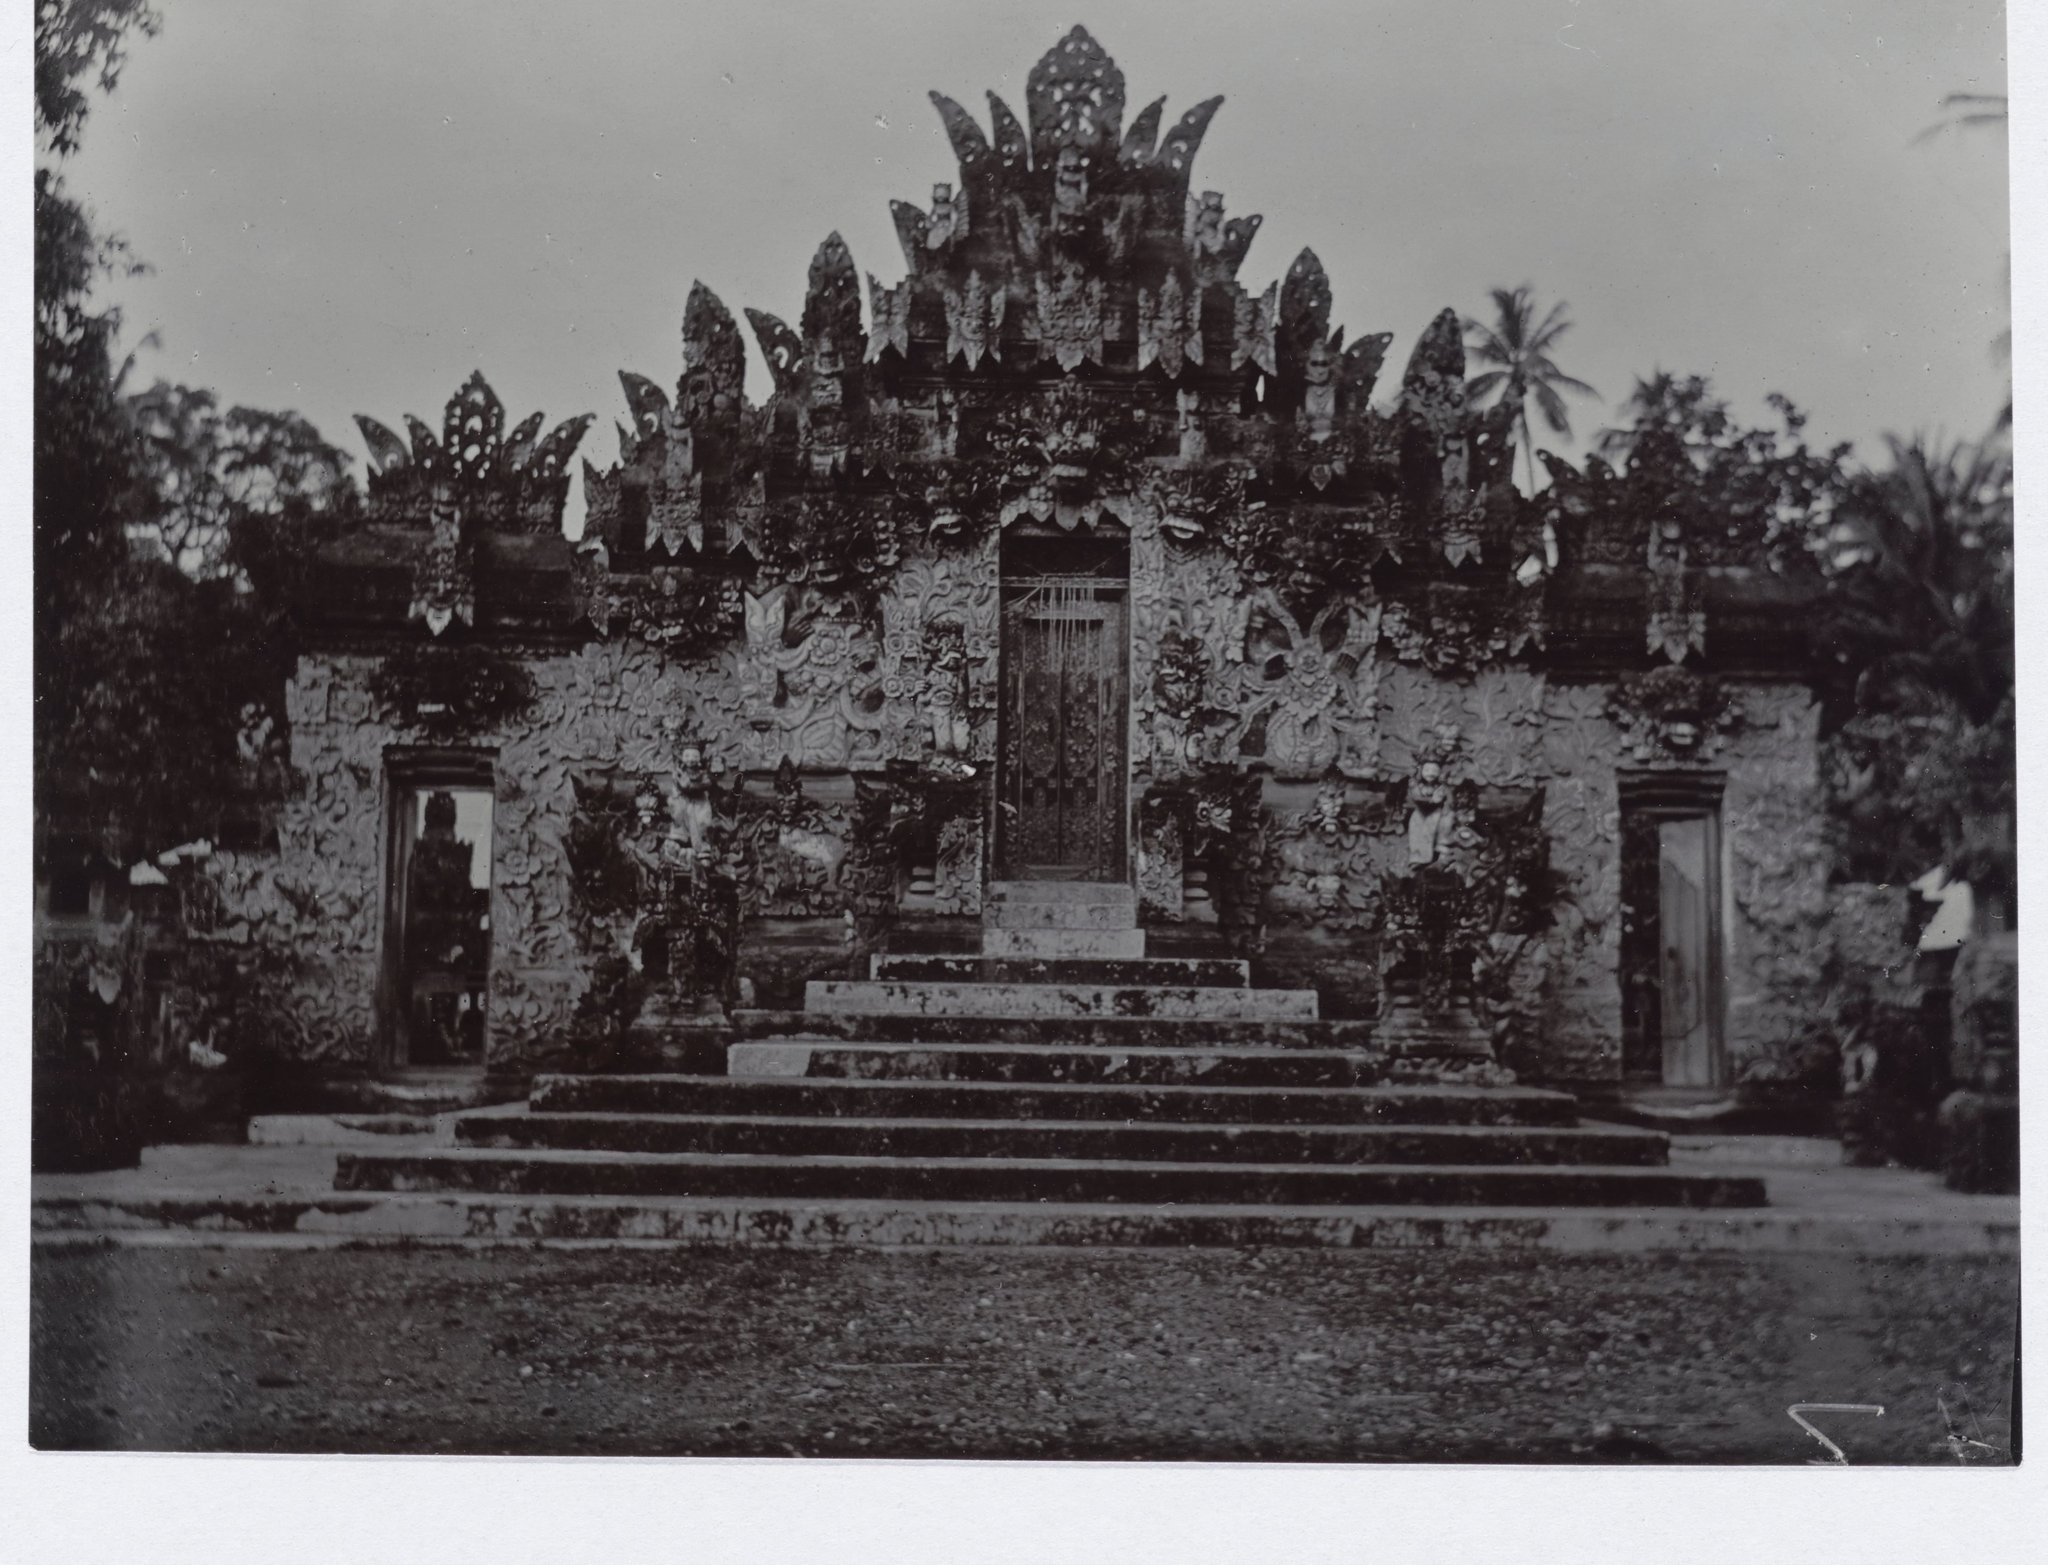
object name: photograph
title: Een rijk gedecoreerde tempelpoort bij Pura Sangsit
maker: johanna hermina marmelstein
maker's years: 1897-1990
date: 1900-1915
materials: paper, photographic support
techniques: albumen print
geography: jakarta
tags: bali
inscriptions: annotation: ‘20. Noord Bali. Buitenpoort van de poera te Sangsit bij Singaradja.’